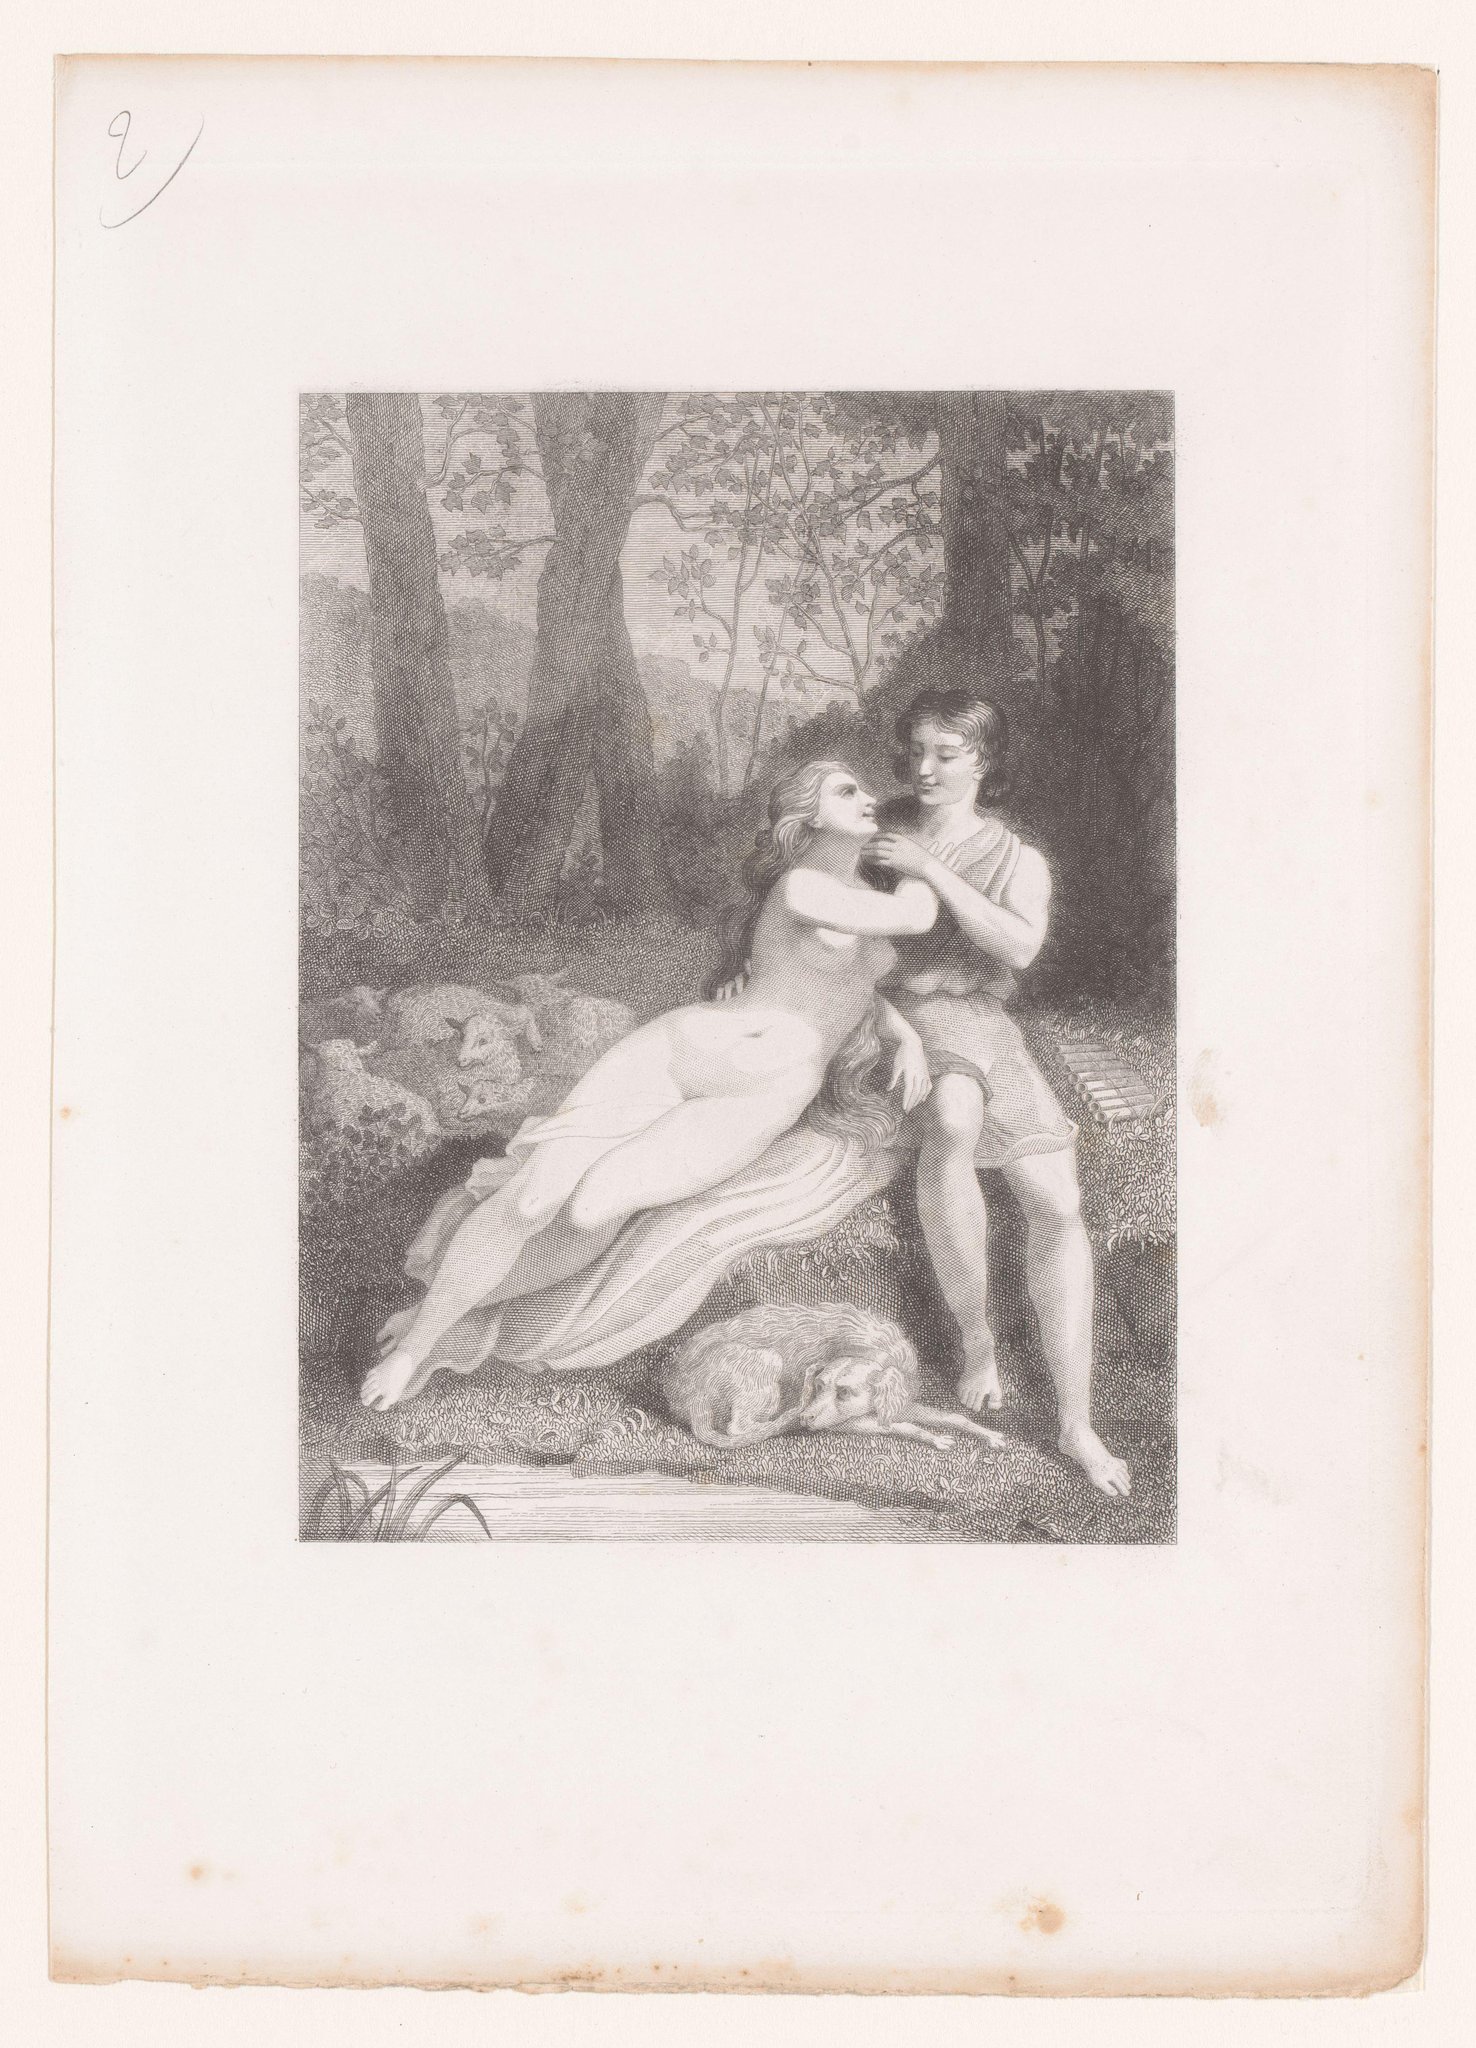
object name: print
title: Daphnis en Chloë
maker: Anonymous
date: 1820-1860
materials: paper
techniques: engraving, etching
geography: paris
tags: daphnis (in greek mythology a shepherd who invented pastoral poetry, chloe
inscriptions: collector's mark: Lugt 2228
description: Compositie geïnspireerd op "Venus en Adonis" van Pierre Prud'hon, maar bewerkt tot Daphnis en Chloë.